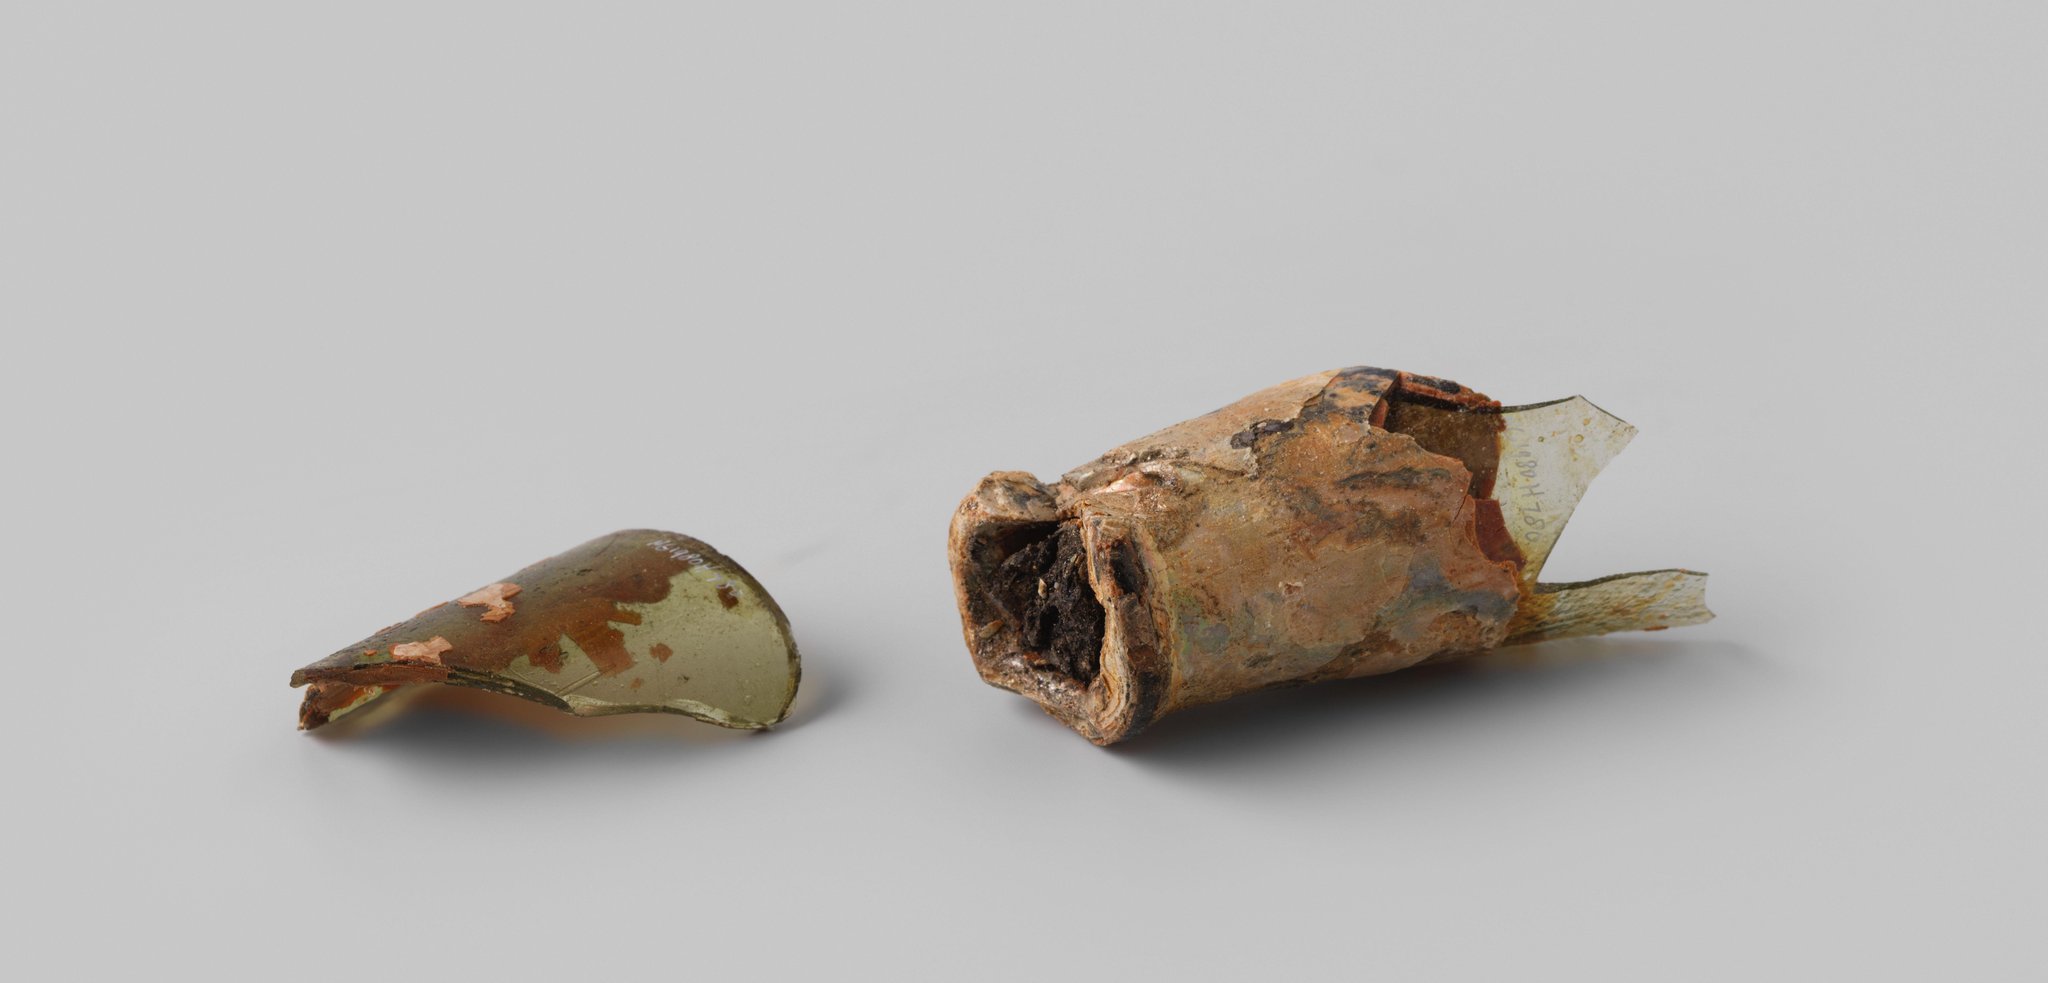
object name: wine bottle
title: Fragment hals met kurk en glasscherf van een wijnfles uit het wrak van de Oost-Indiëvaarder Hollandia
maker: Anonymous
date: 1700-1743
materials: glass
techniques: green glass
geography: netherlands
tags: verenigde oostindische compagnie, hollandia (schip), annet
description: Wine bottle, continental production, neck, onion-shaped bottle or bottle with vertical side; fragm, f-string rim.